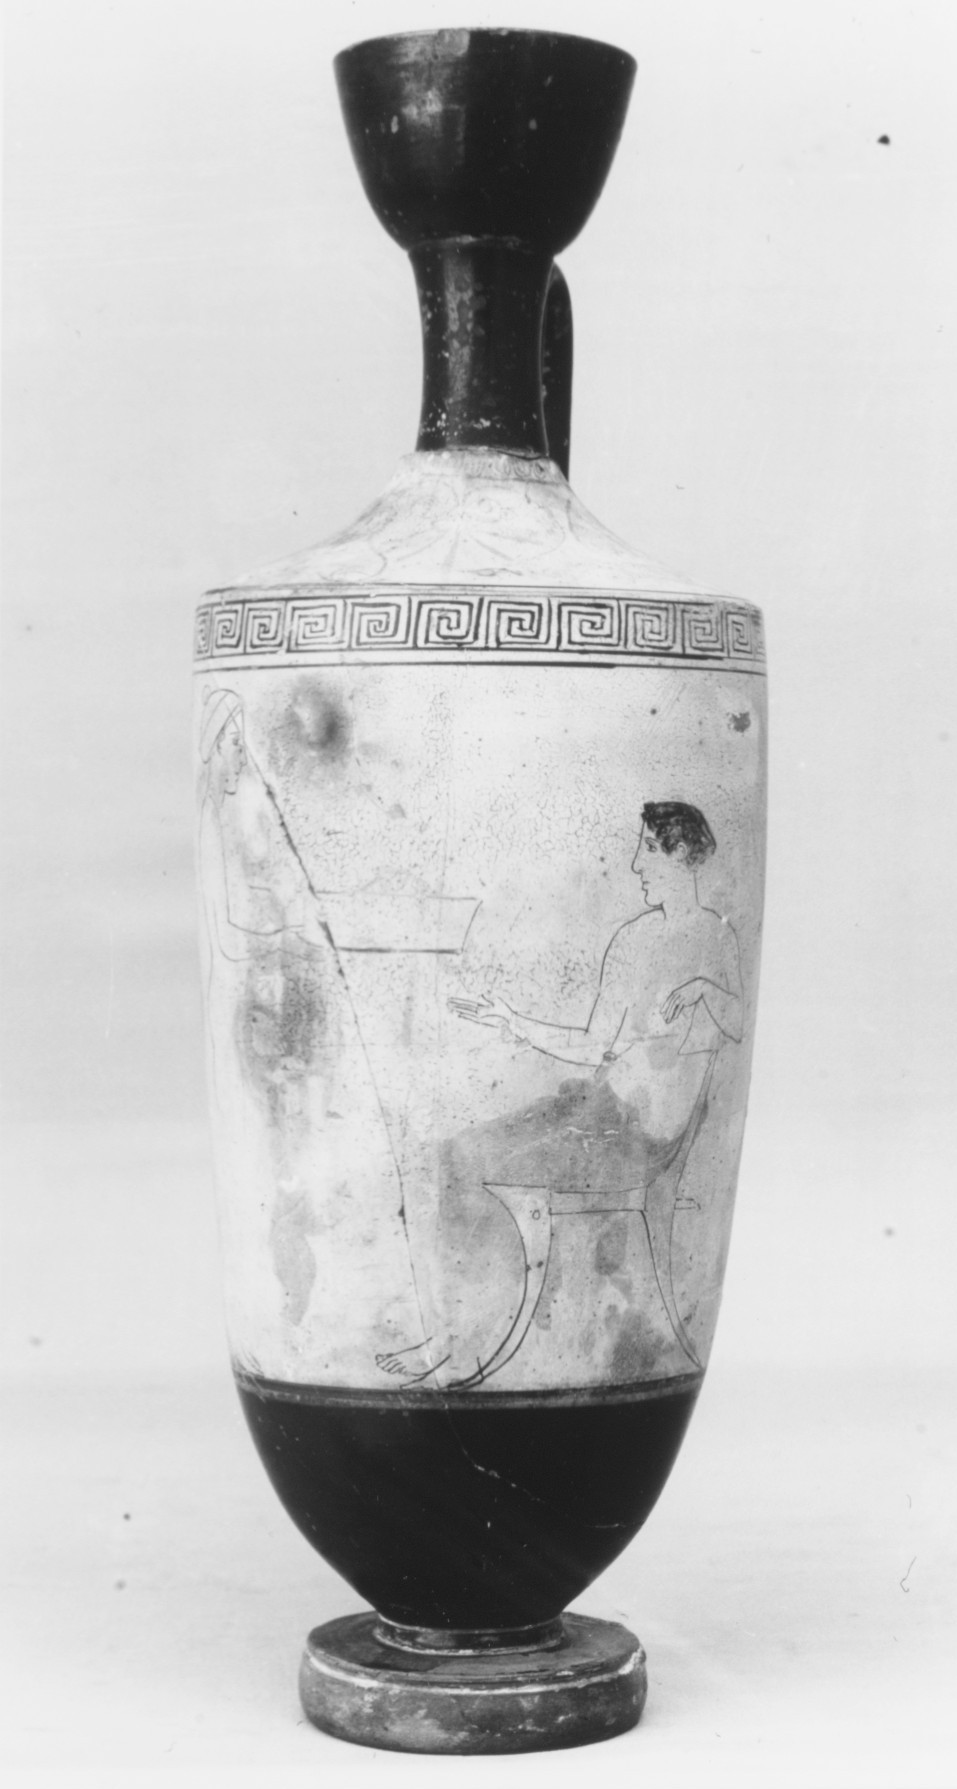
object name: lekythos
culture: greek, attic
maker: thanatos painter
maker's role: artist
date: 440-430 BCE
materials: terracotta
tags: women